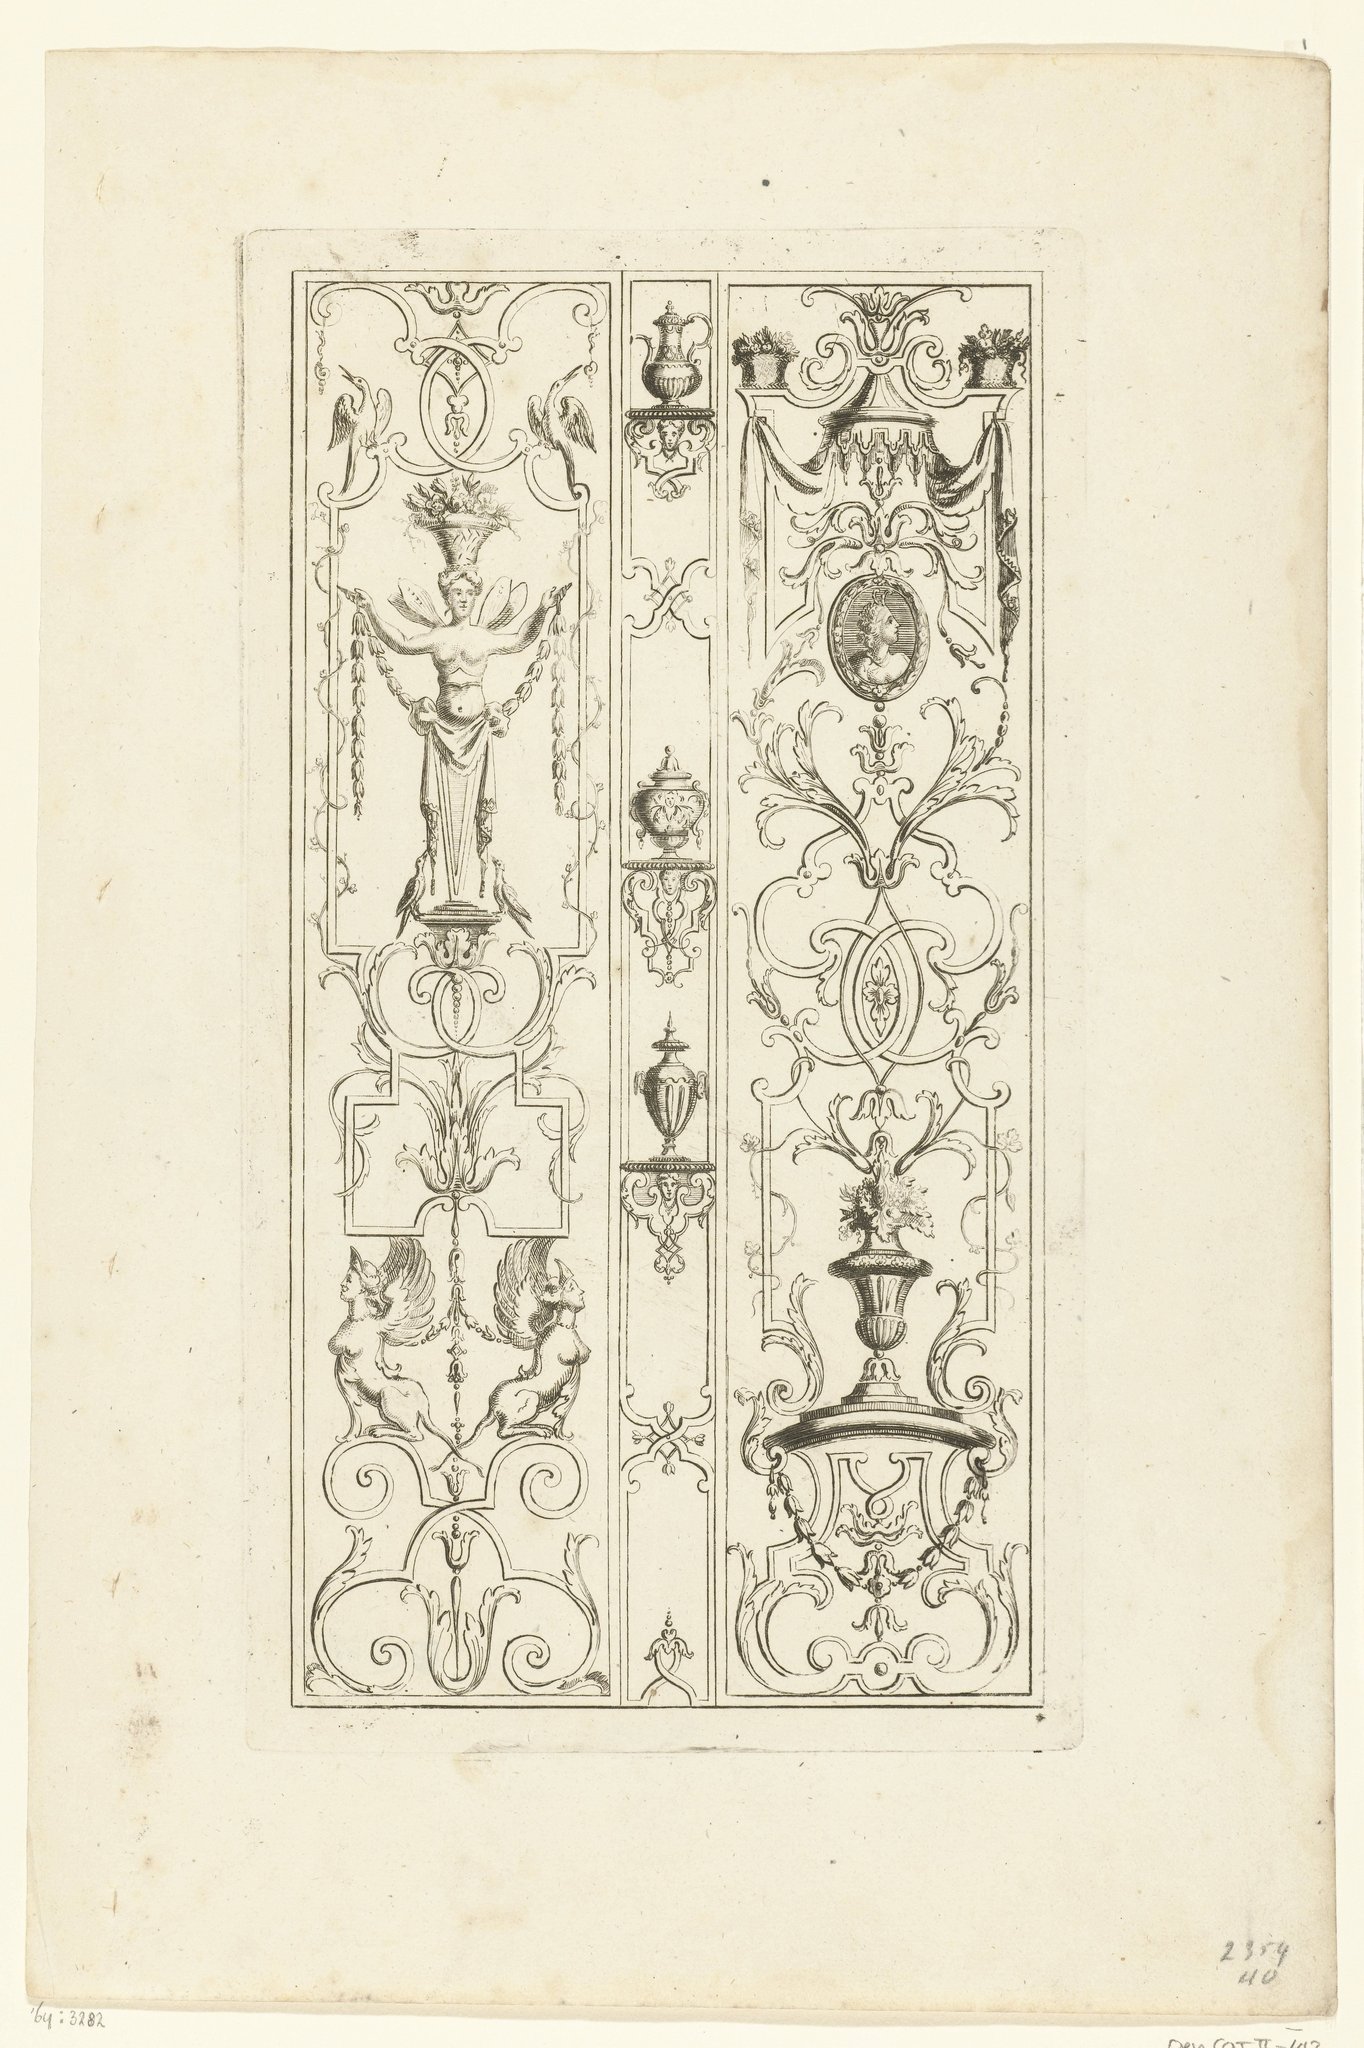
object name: print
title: Panelen met vrouwelijke herme en medaillion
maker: Anonymous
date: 1650-1761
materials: paper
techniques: etching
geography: france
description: In het midden van het linkerpaneel staat een herme met een mand vol bloemen op haar hoofd, bovenaan het rechterpaneel hangt een portretmedaillon onder een baldakijn. Blad uit serie met moderne grotesken waartussen zich ornamenten en consoles met serviesgoed bevinden.